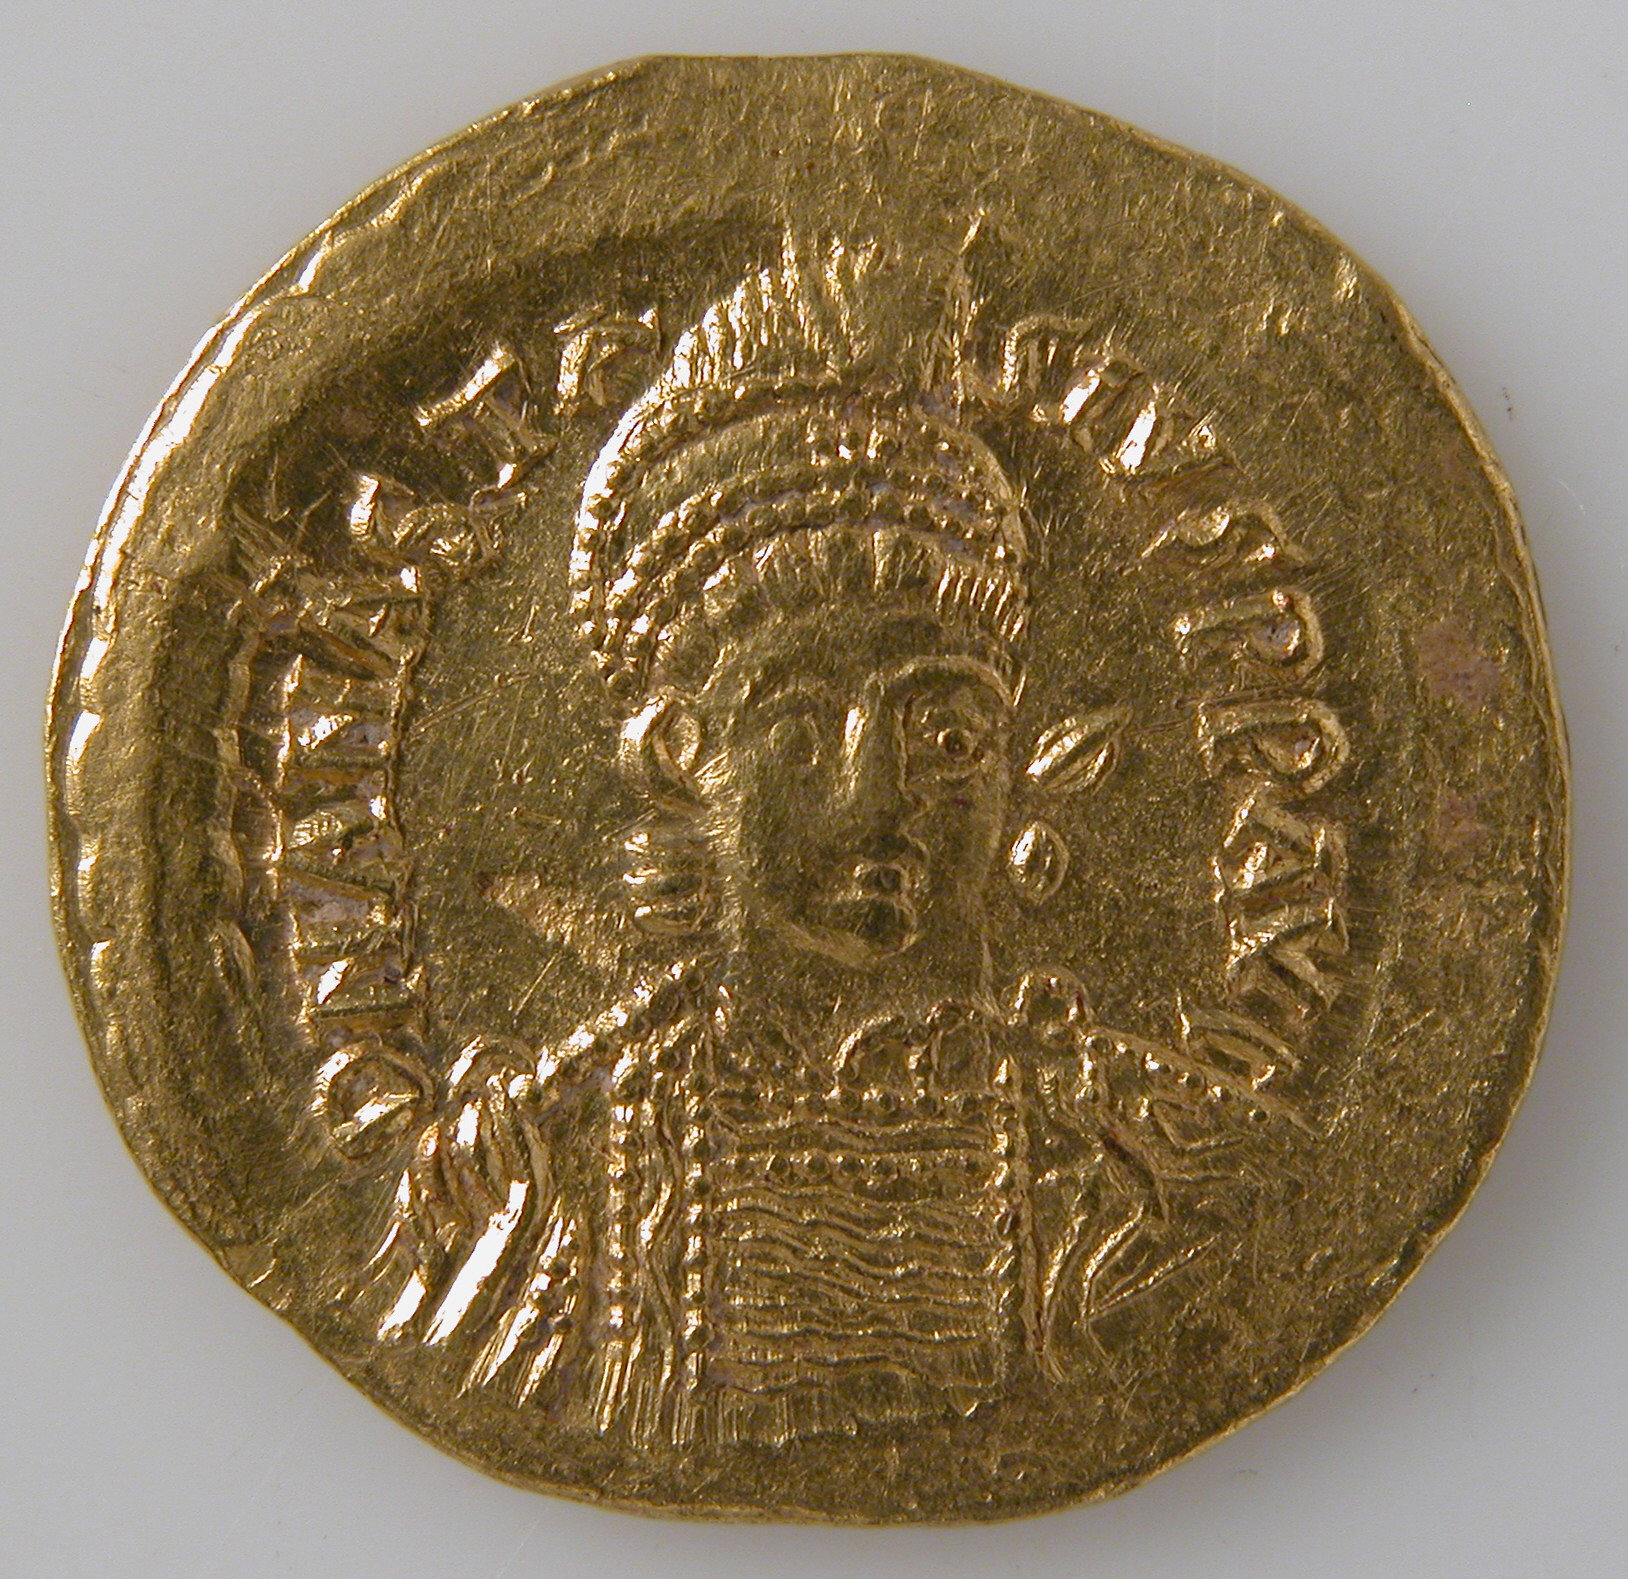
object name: solidus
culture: byzantine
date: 491-518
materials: gold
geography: constantinople